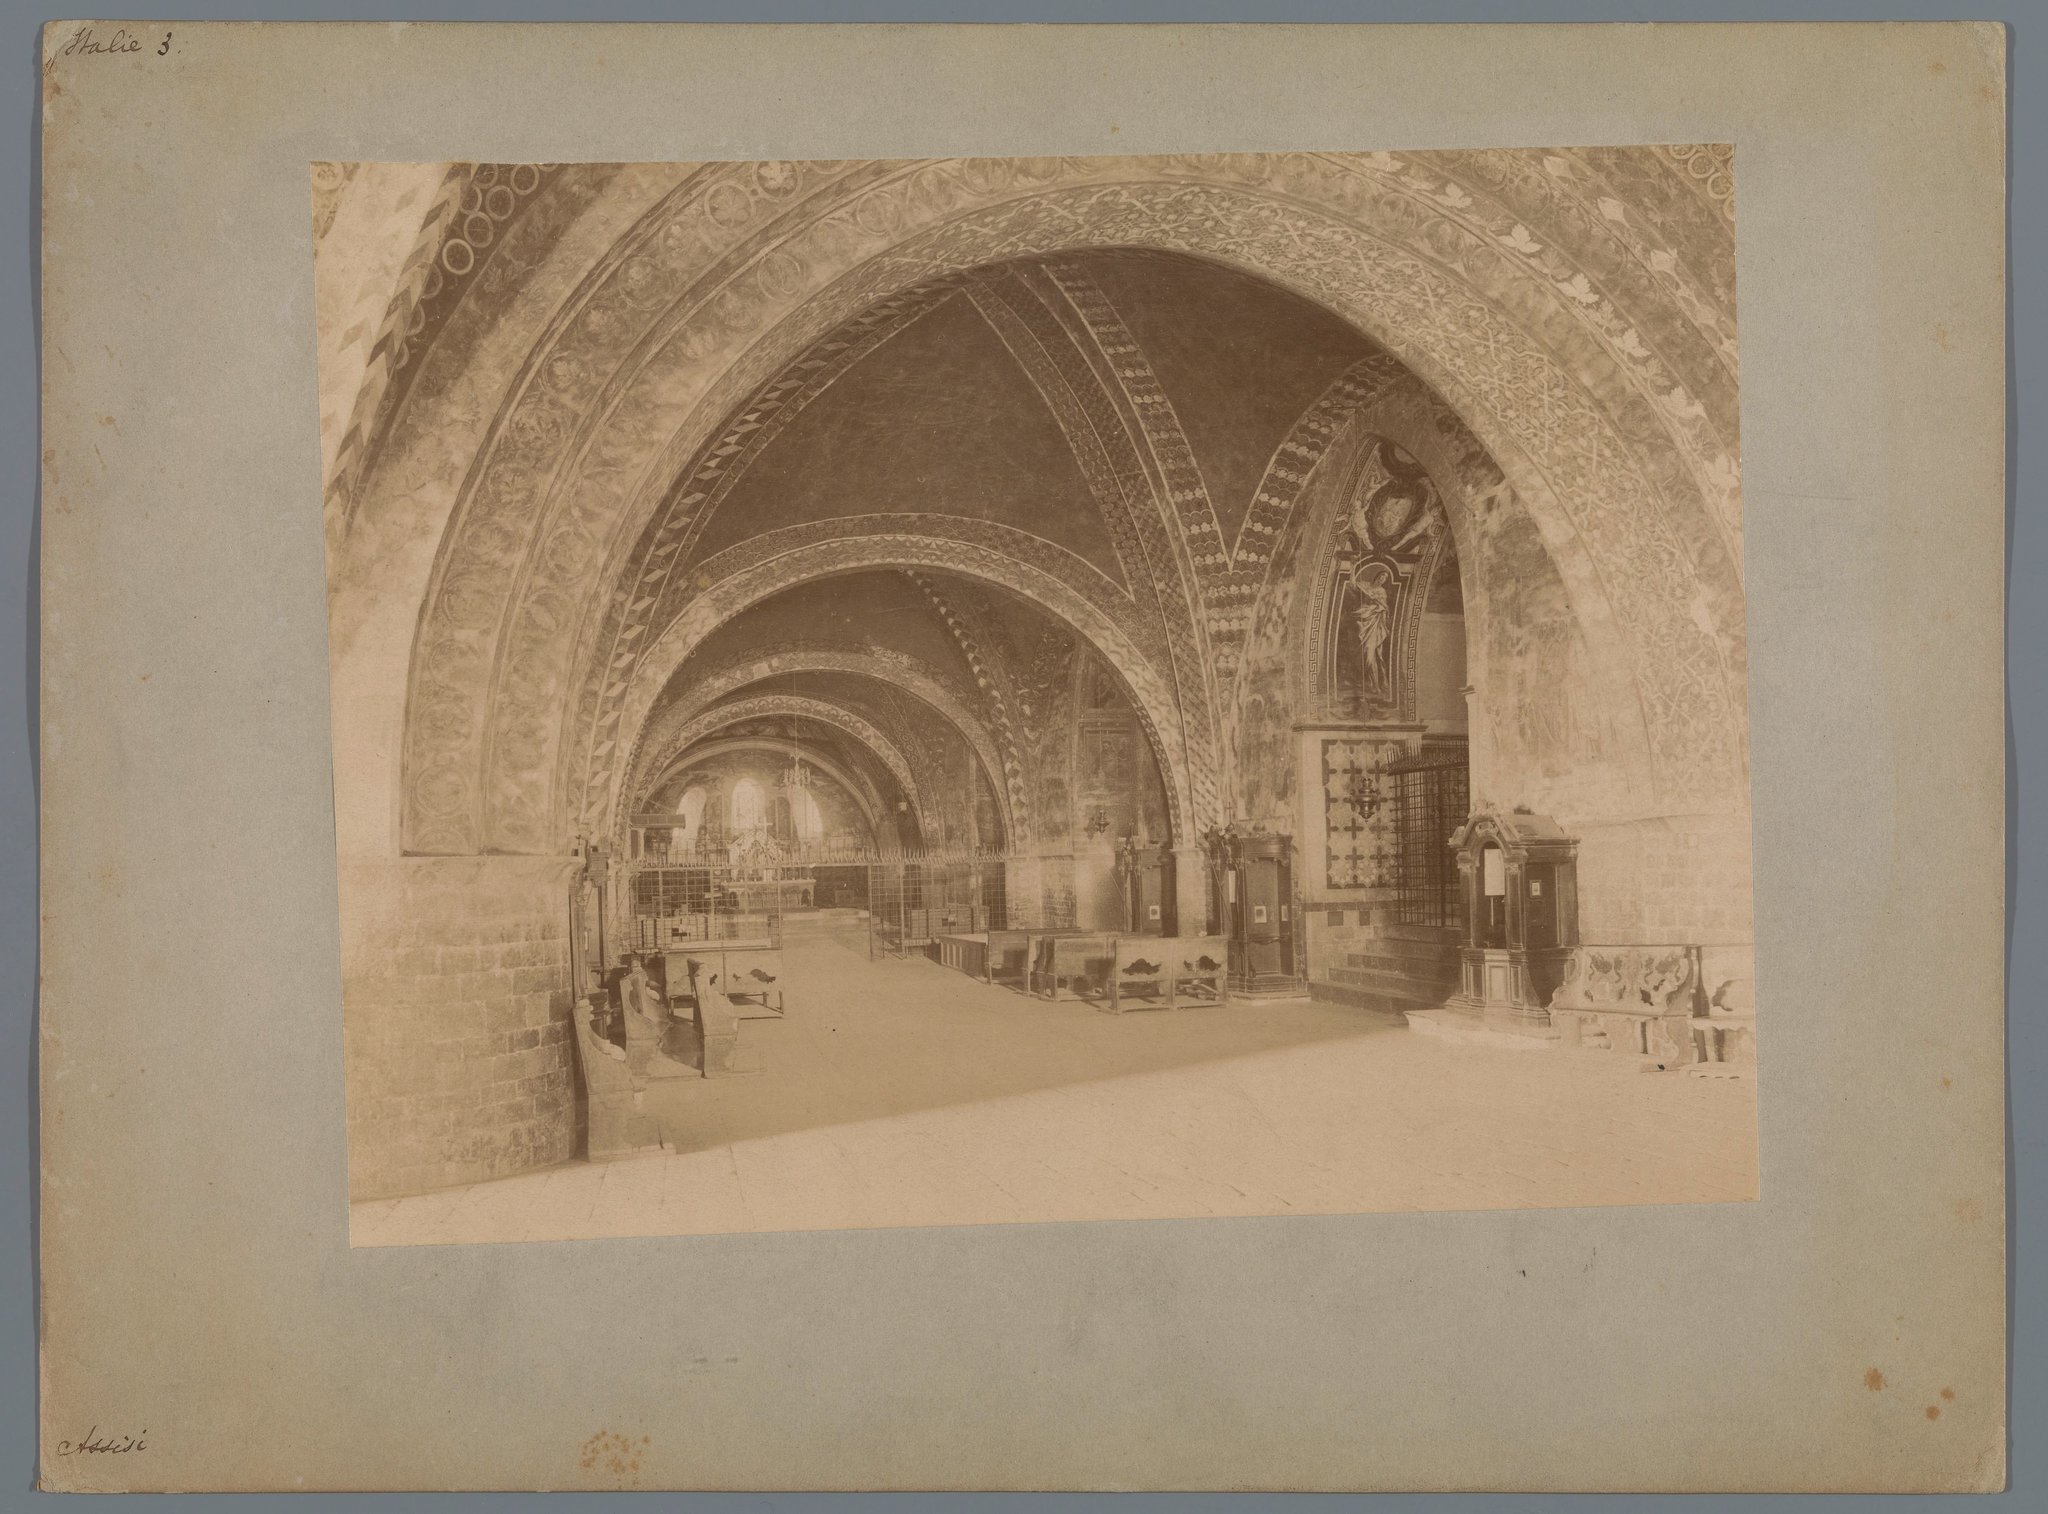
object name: photograph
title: Crypte van Franciscus van Assisi in de Sint-Franciscusbasiliek te Assisi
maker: Anonymous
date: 1875-1900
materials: cardboard, photographic support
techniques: albumen print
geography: s. rufino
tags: parts of church interior: vault, interior of church, parts of church interior (crypt)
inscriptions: collector's mark: ‘RIJKS-NORMAALSCHOOL-VOOR-TEEKENONDERWIJZERS-AMSTERDAM’, number: ‘Italie 3.’